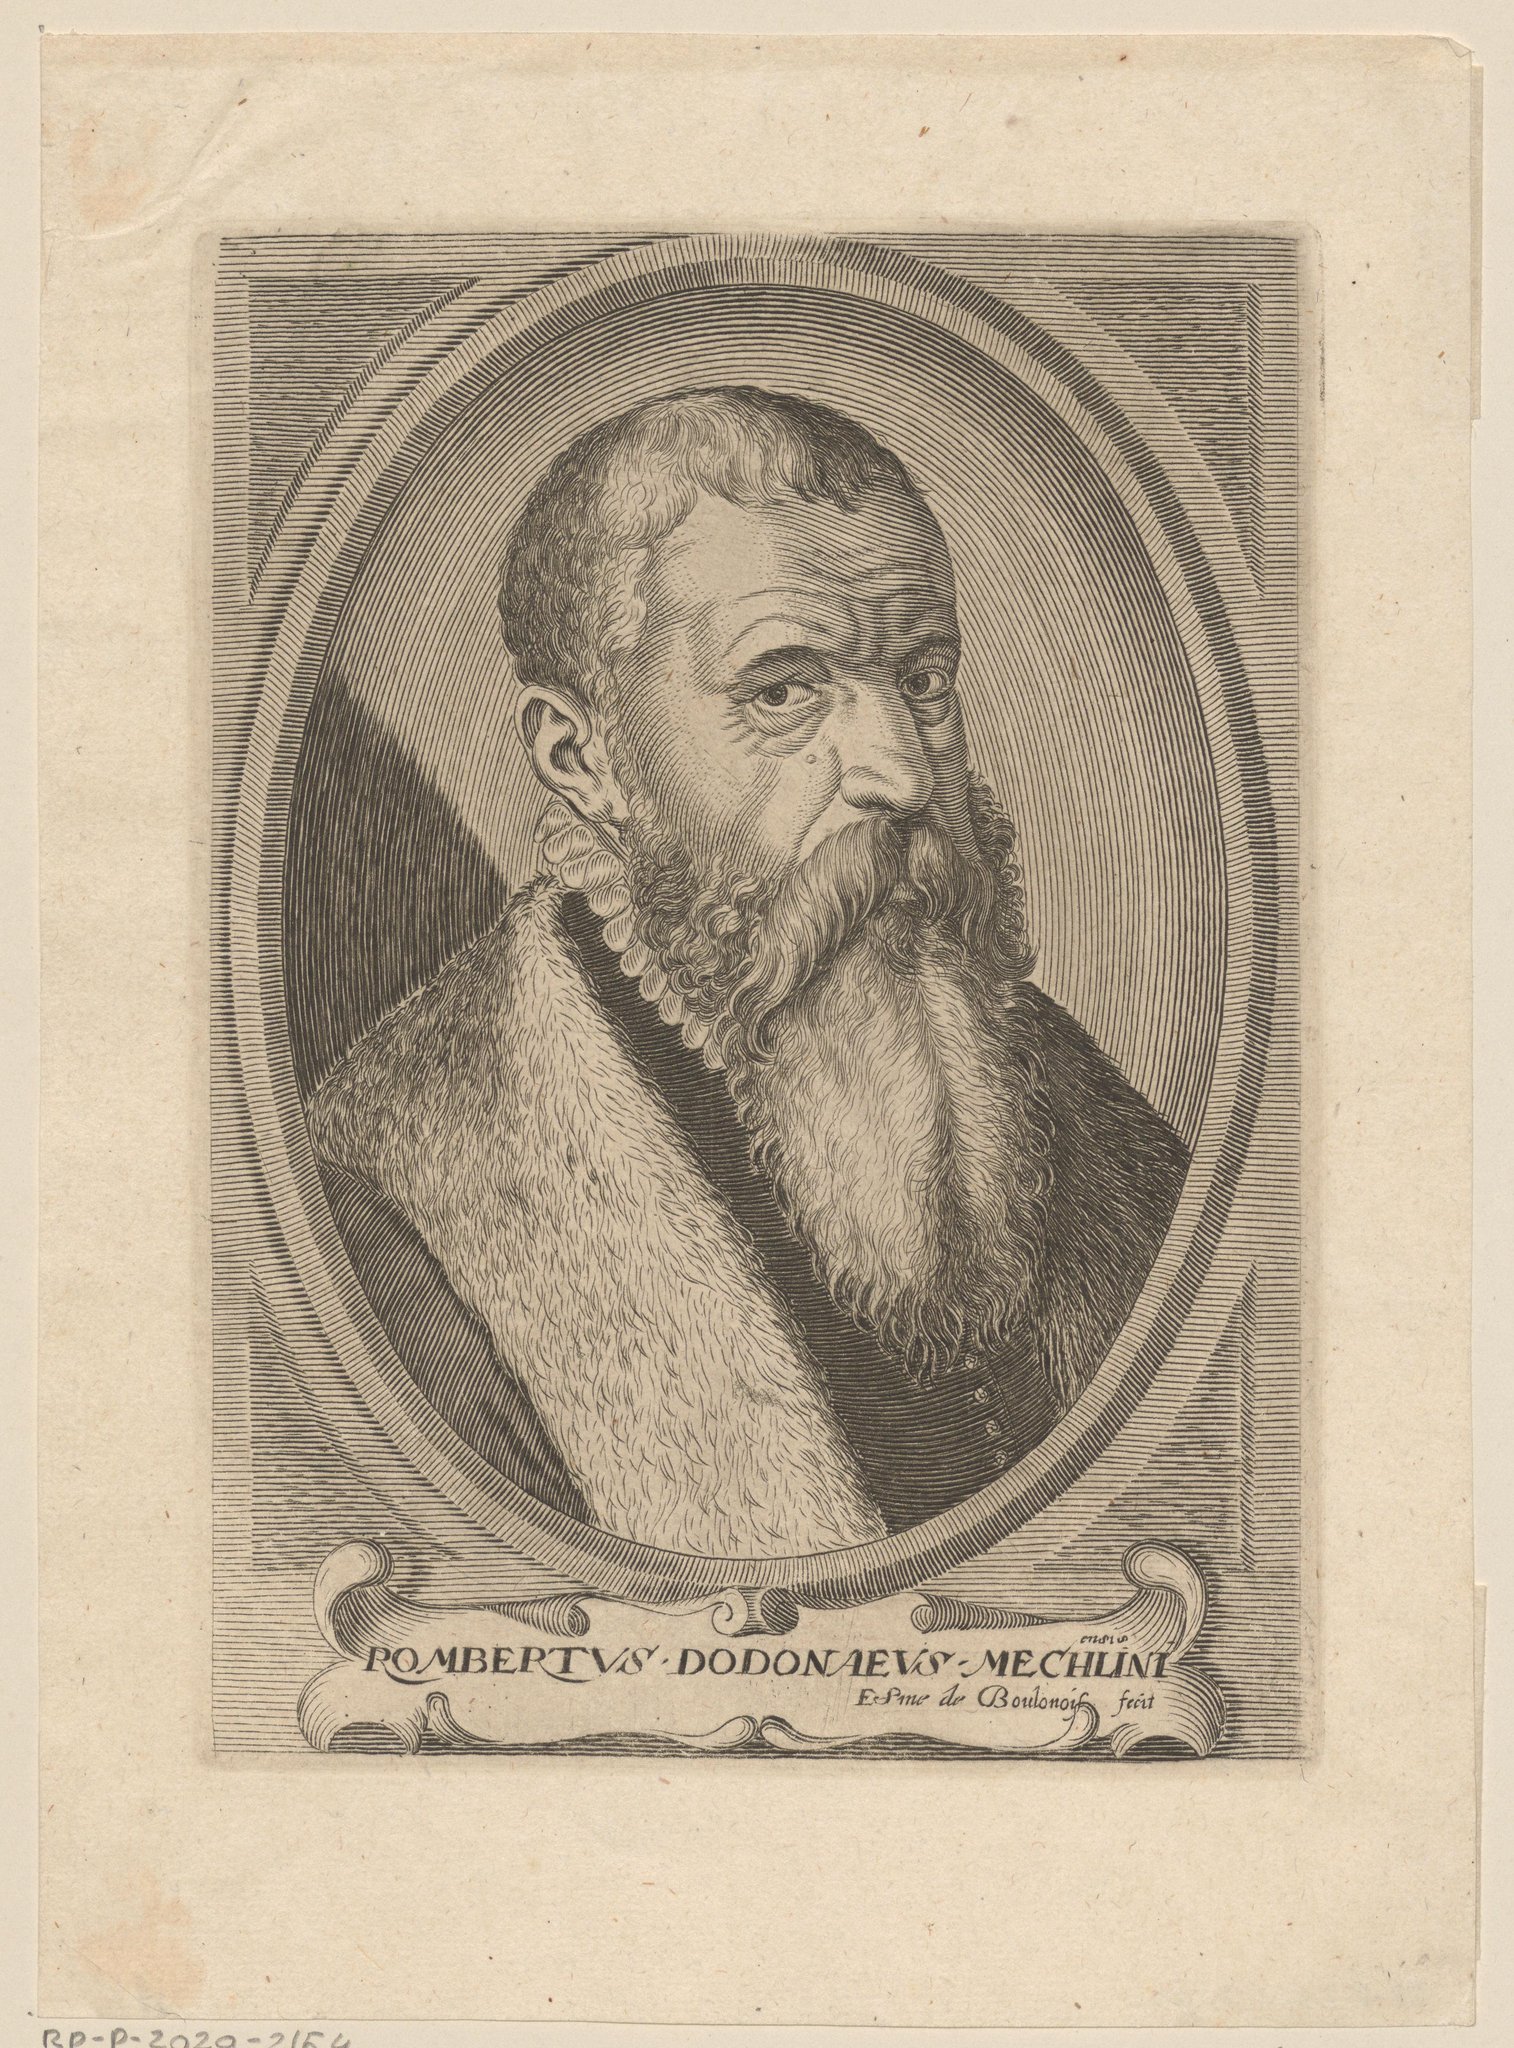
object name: print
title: Portret van Rembertus Dodonaeus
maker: edme de boulonois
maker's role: print maker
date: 1682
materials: paper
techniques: engraving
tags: mechelen, leiden, rembertus dodonaeus, historical persons, physician, doctor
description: Prent met tekst op recto en verso gebruikt in: Bullert, Isaac. Académie des Sciences et Arts contenant les vies et éloges (...). Brussel: François Foppens, 1682.